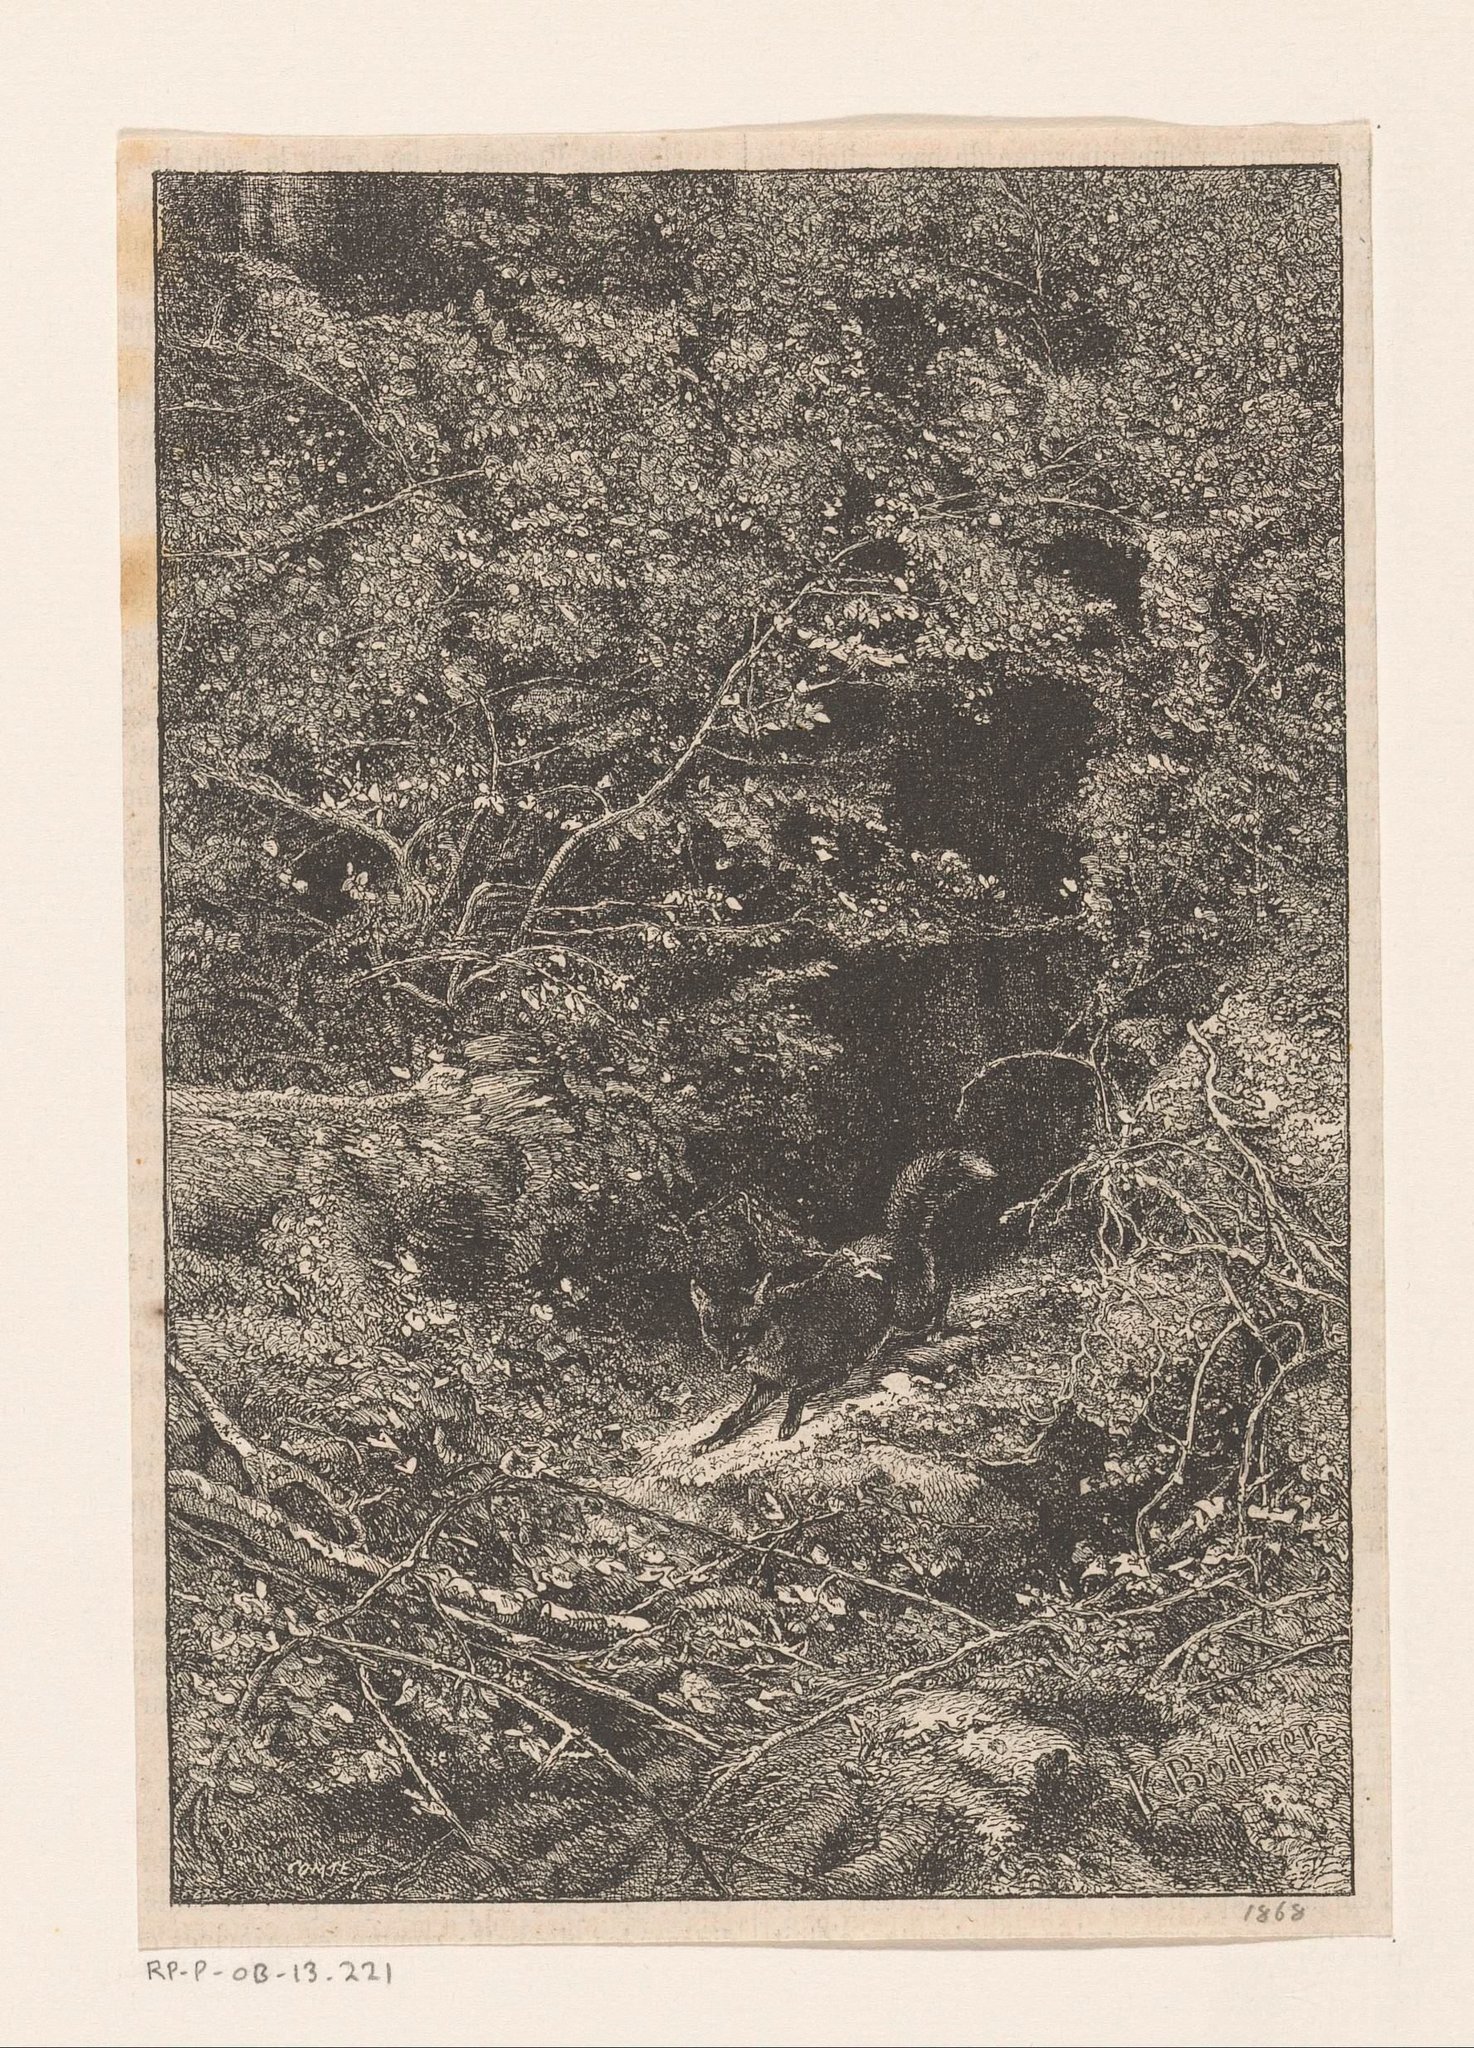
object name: print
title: Vos in het struikgewas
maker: karl bodmer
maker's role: draughtsman, painter, print maker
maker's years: 1809-1893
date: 1868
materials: paper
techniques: lithography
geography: barbizon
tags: beasts of prey, predatory animals: fox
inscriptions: collector's mark: Lugt 2228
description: Prent afkomstig uit: Le Magasin pittoresque 36 (1868), p. 297.